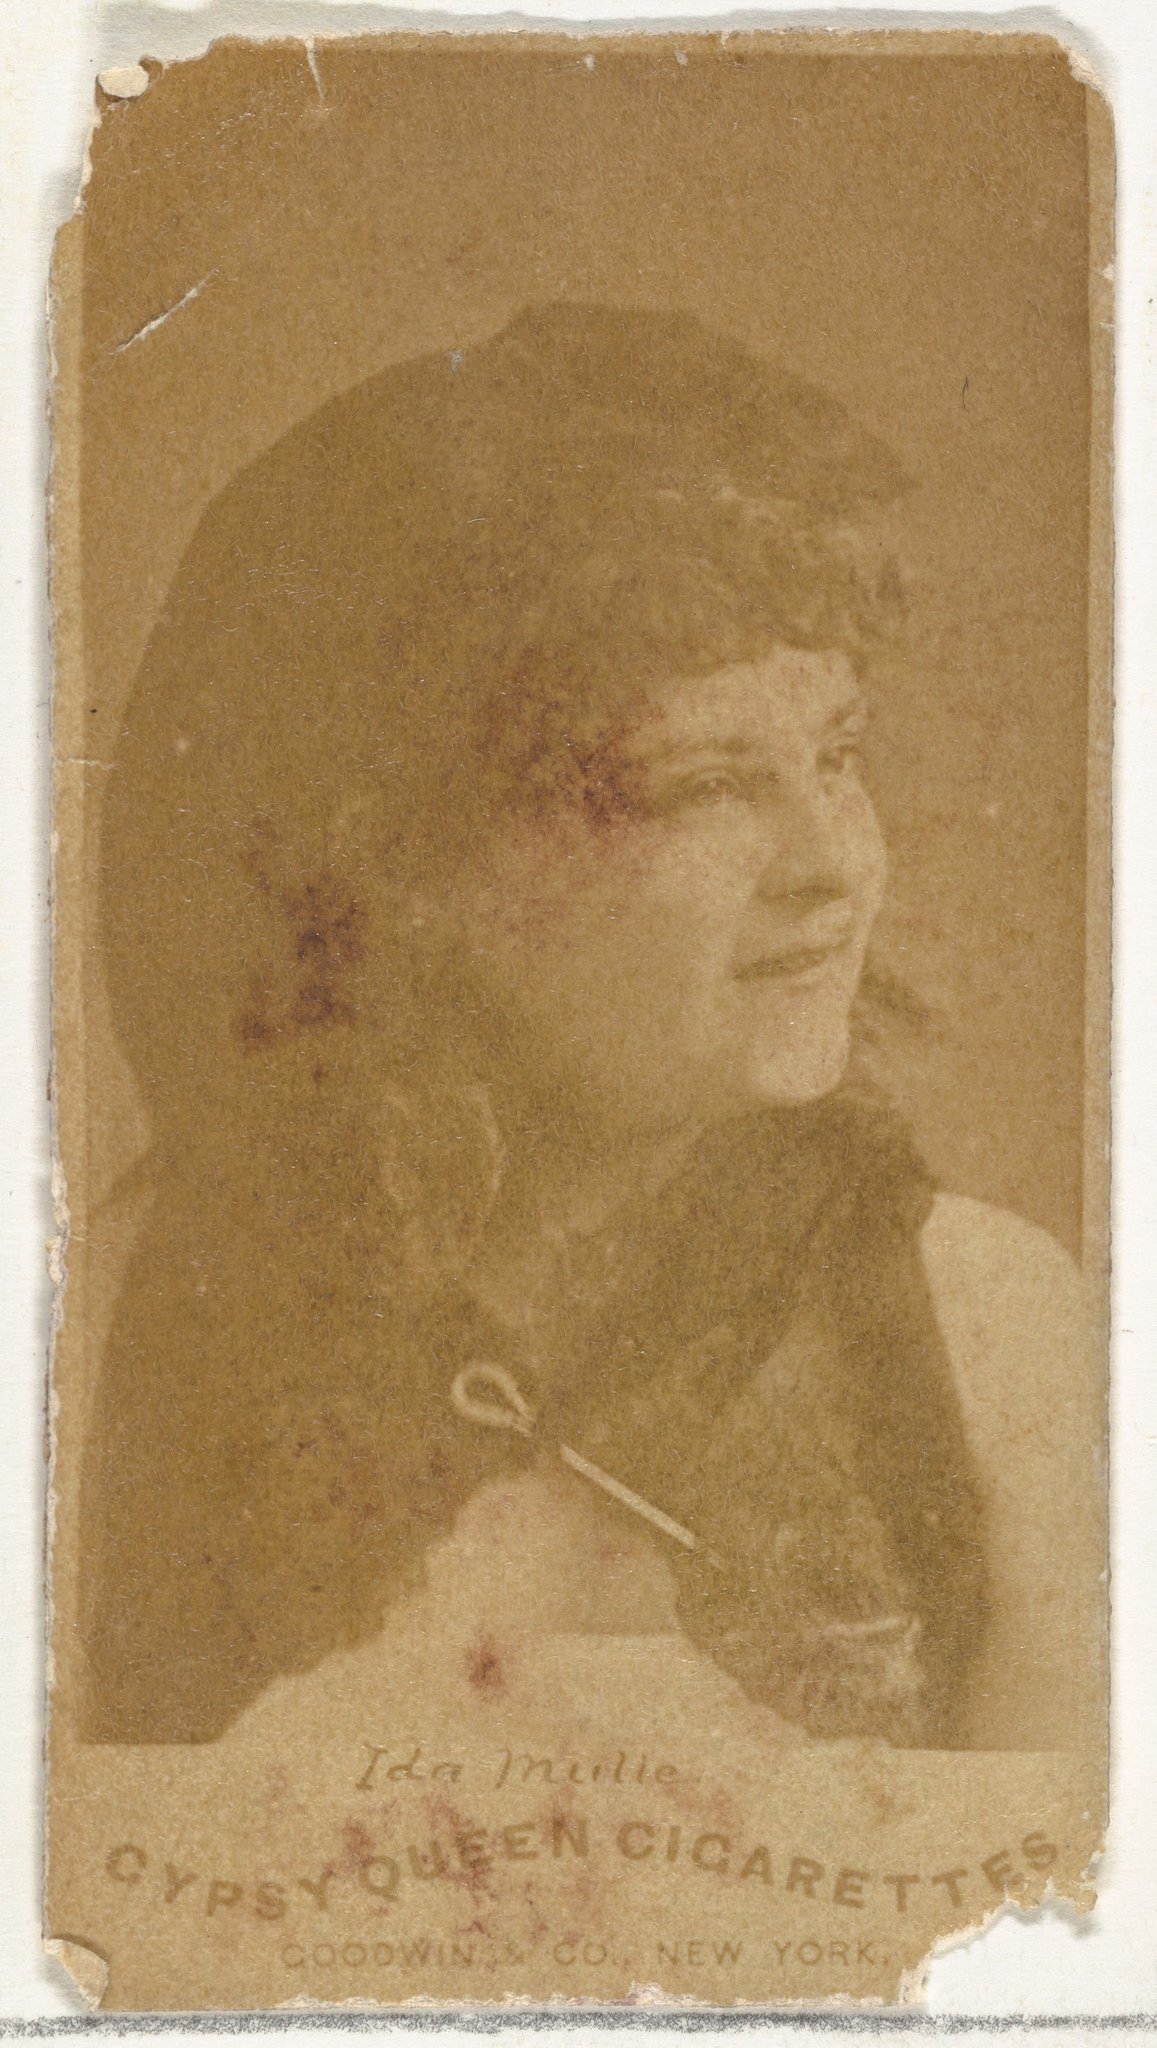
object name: photograph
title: Ida Mulle, from the Actors and Actresses series (N171) for Gypsy Queen Cigarettes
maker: goodwin & company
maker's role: publisher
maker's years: 1850-1950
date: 1886-1890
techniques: albumen silver print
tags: portraits,women,actresses